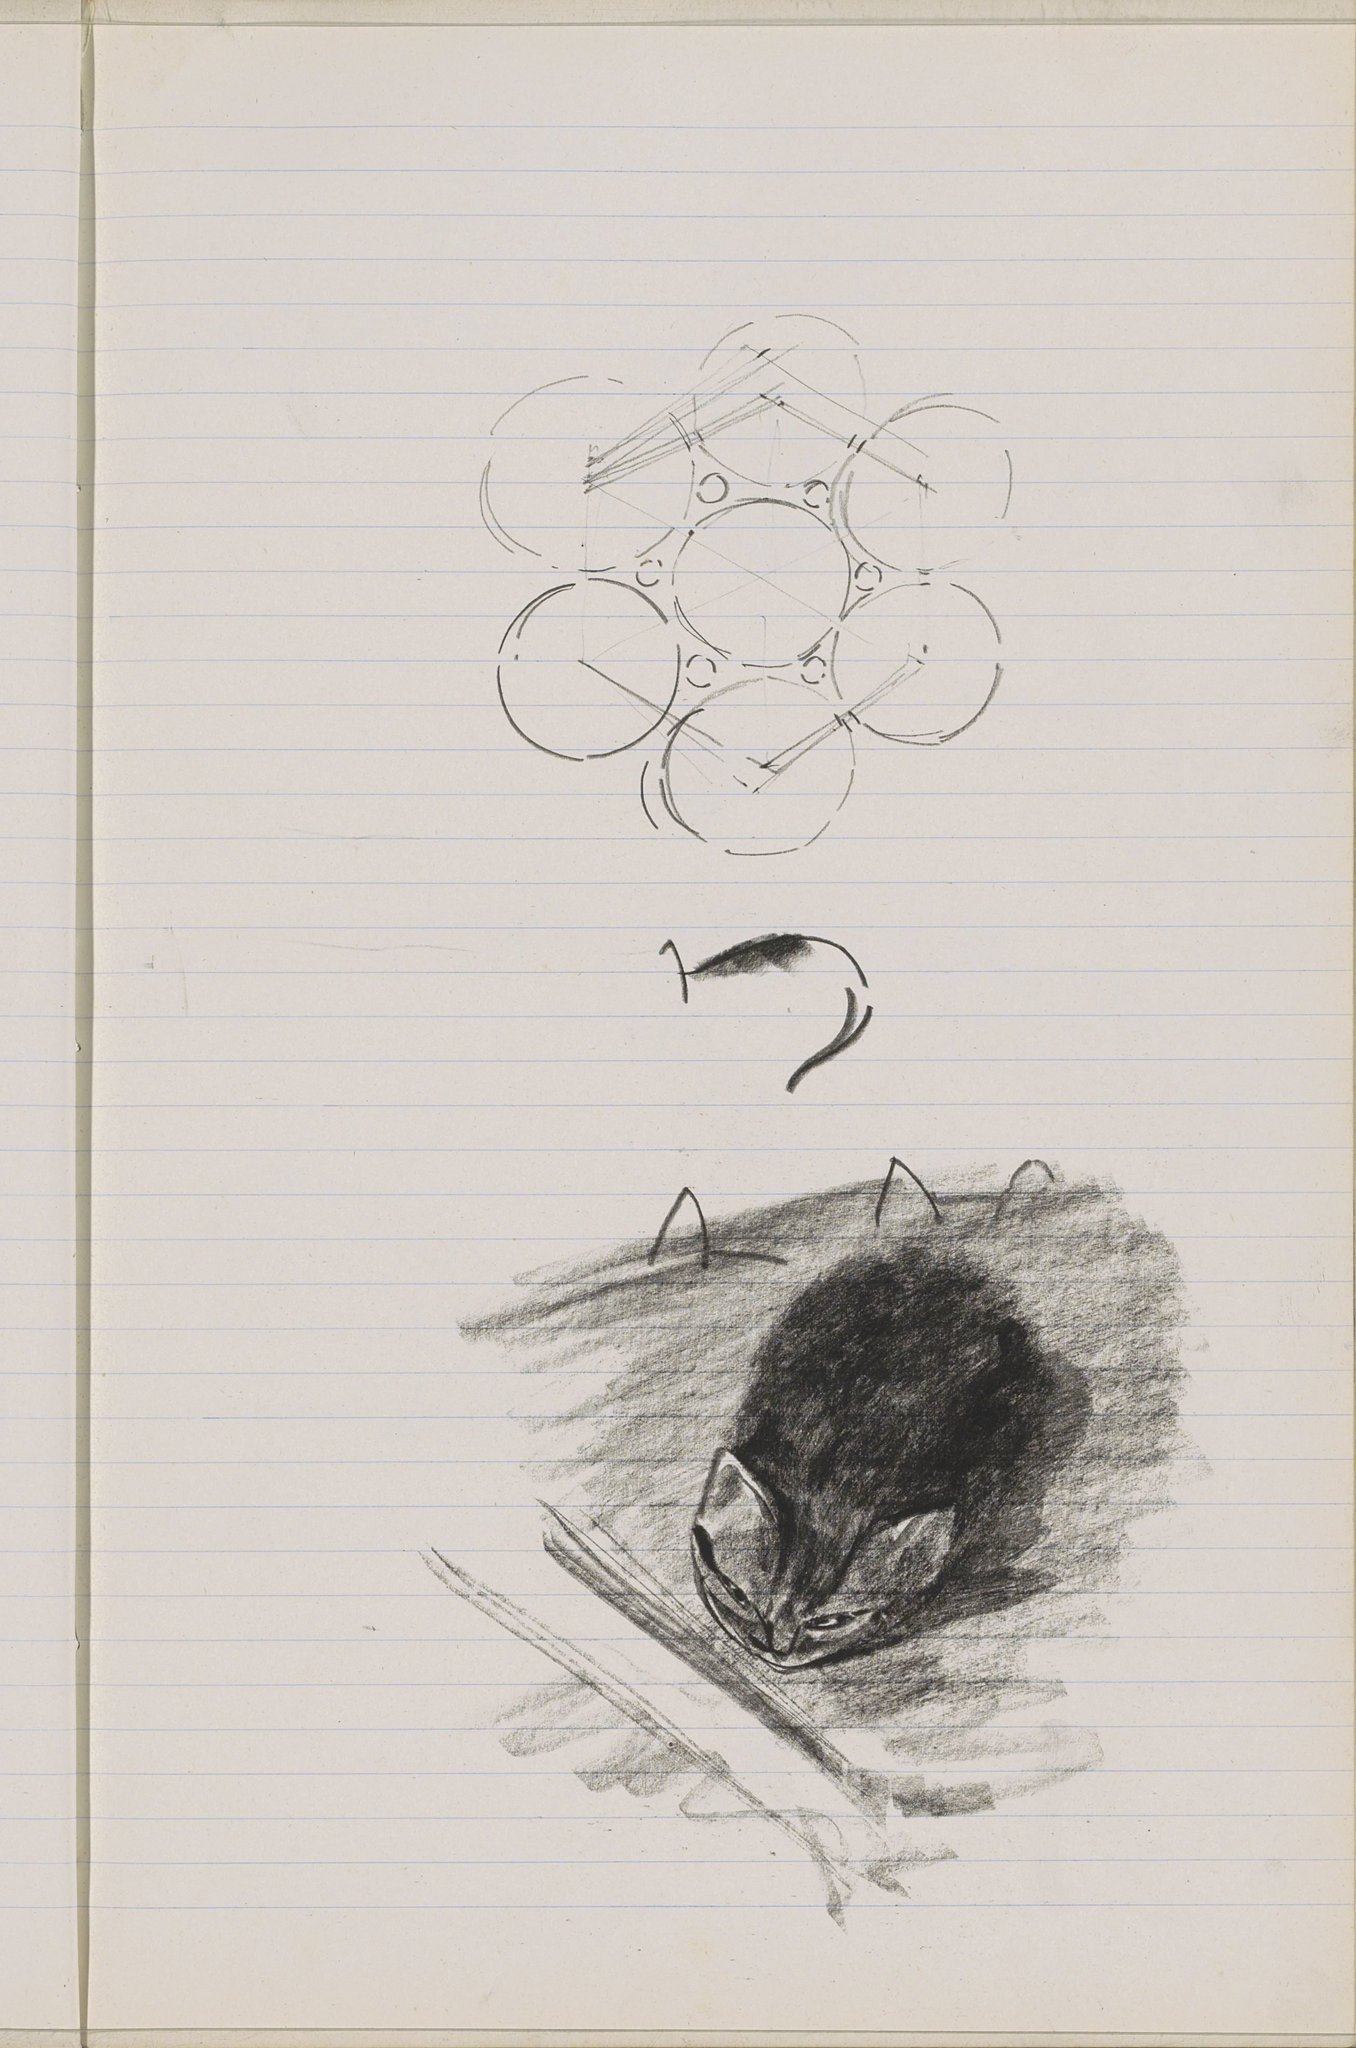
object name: sketchbook leaf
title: Gestileerde bloem en een zittende kat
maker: gerrit willem dijsselhof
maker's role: designer, draughtsman, print maker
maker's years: 1866-1924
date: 1901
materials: chalk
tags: flowers ~ ornament - aa - stylized, cat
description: Blad 70 recto uit een schetsboek met 79 bladen.